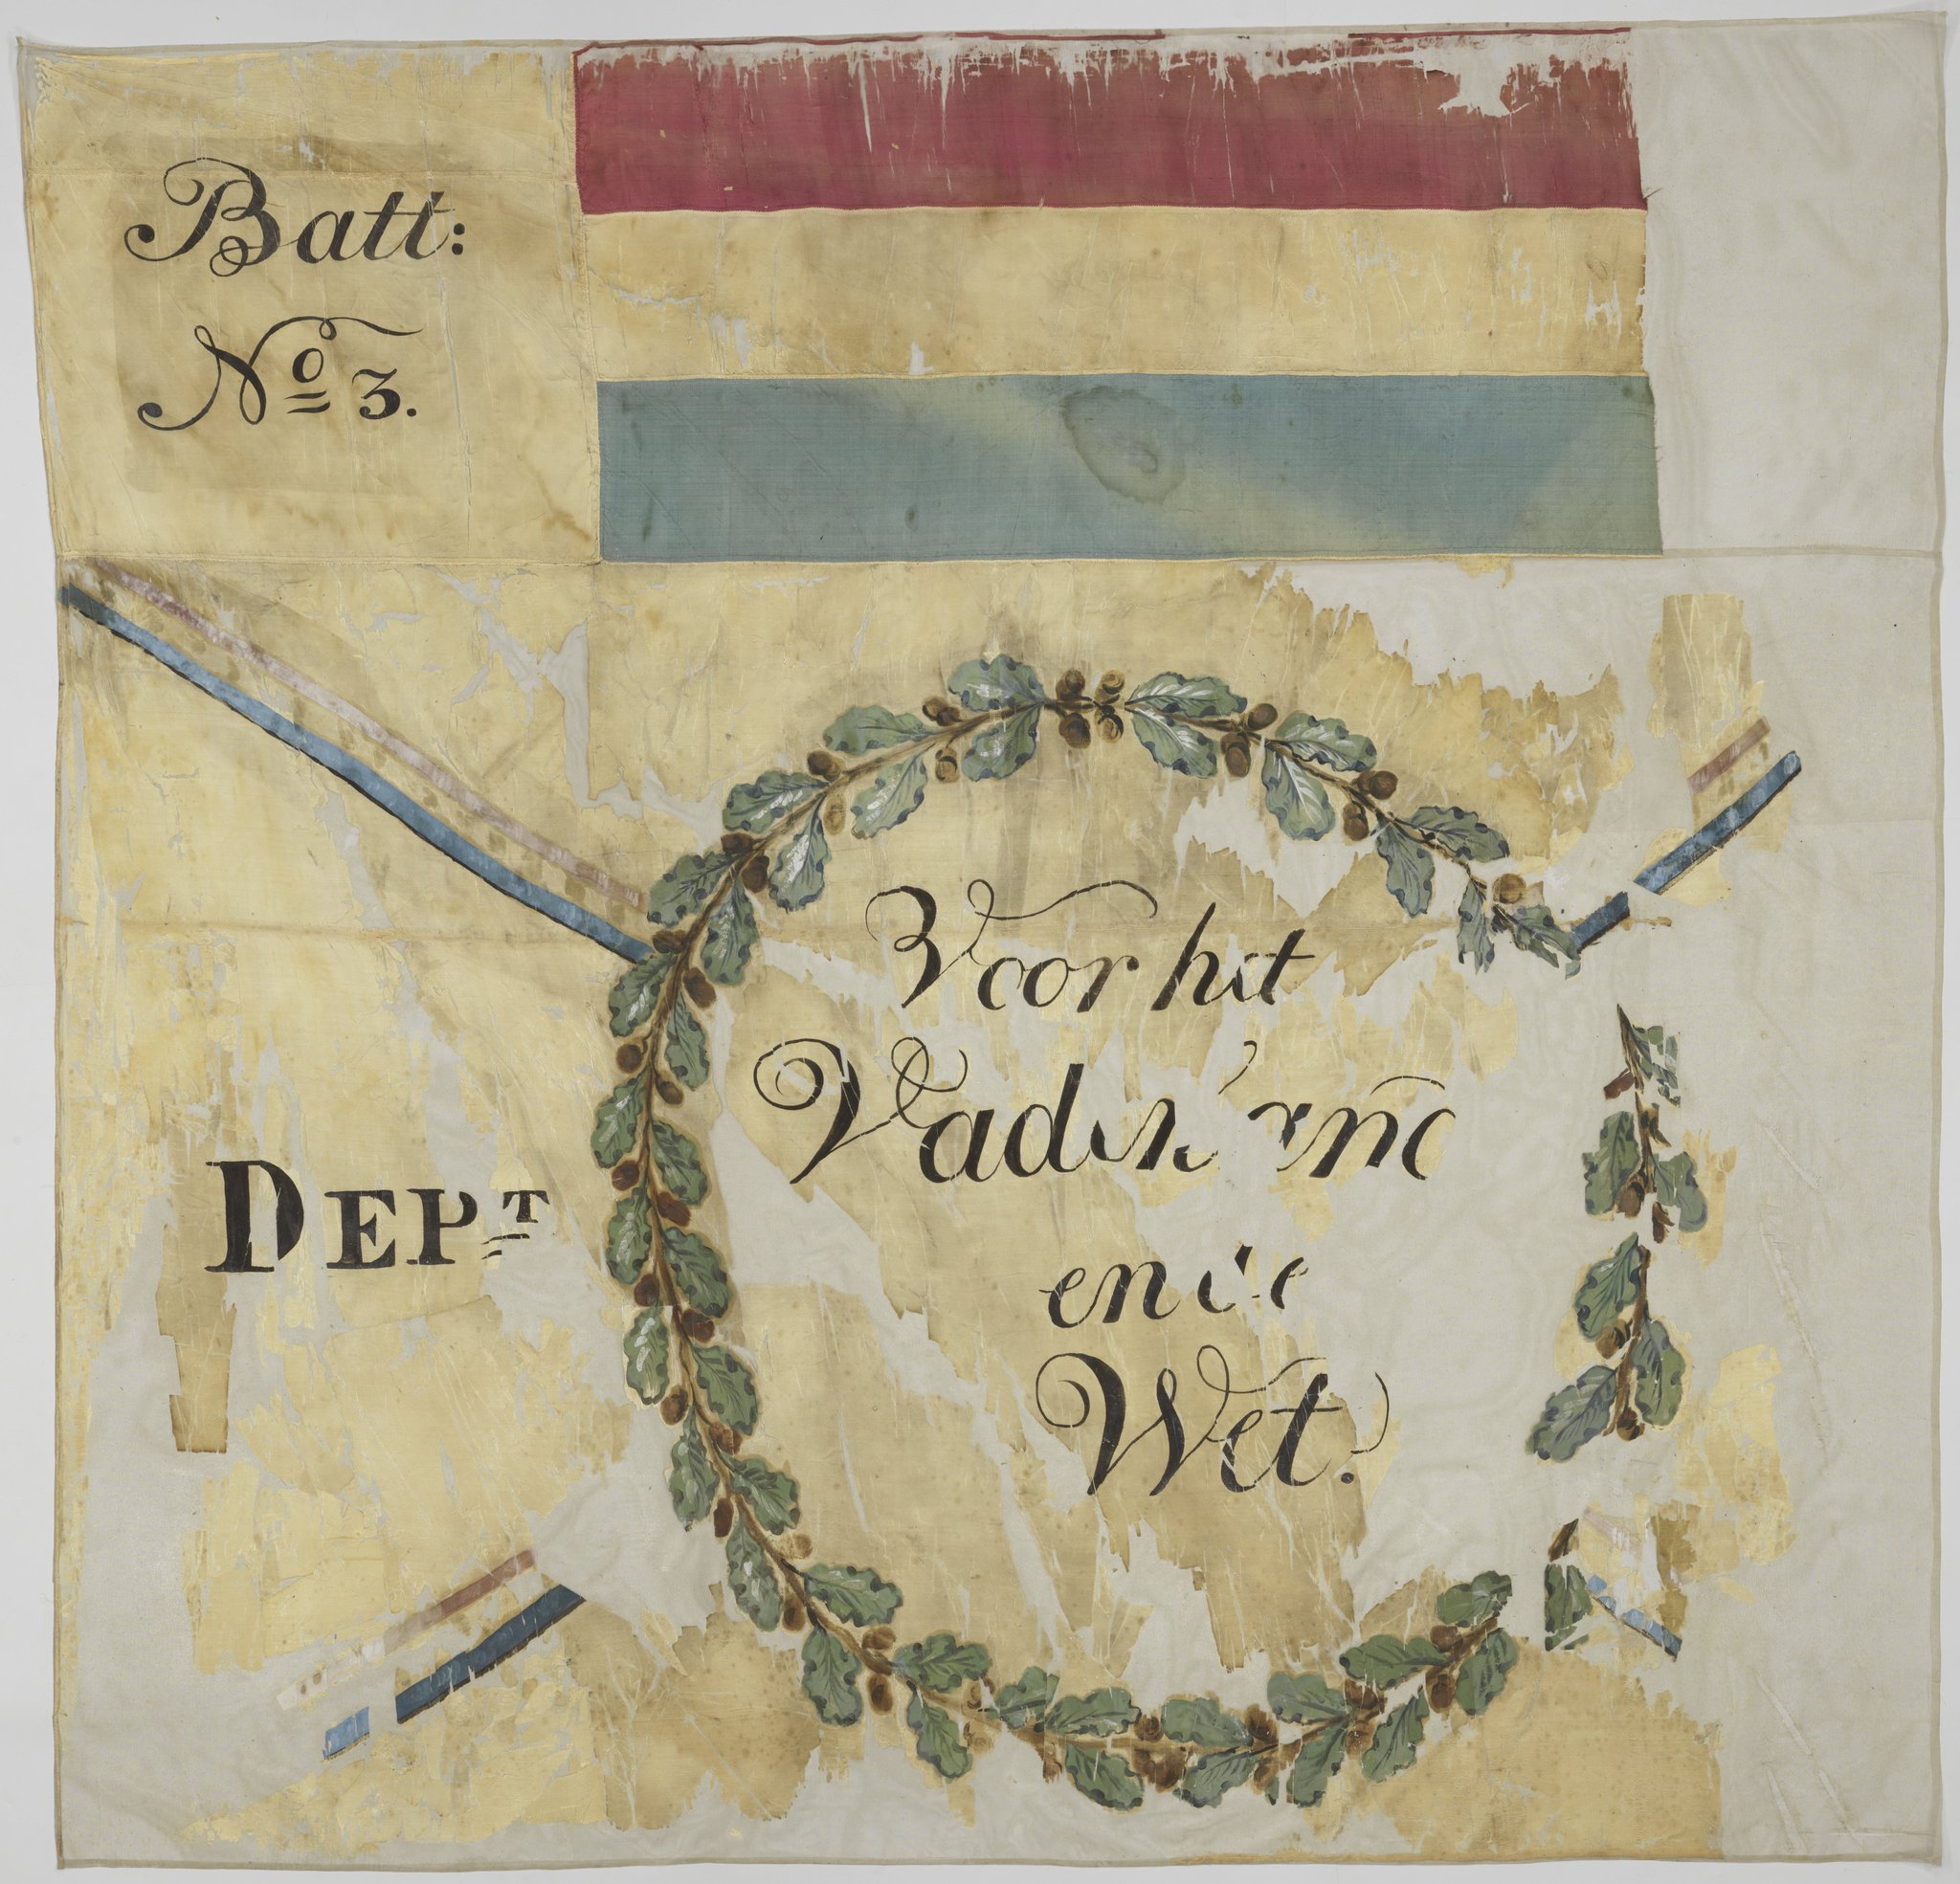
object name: banner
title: Vaandel van het derde bataljon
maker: Anonymous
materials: paint, silk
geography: amsterdam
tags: amsterdam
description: Wit met een krans van eiketakken, waarin met schrijfletters: Voor het Vaderland en de Wet. Diagonaalsgewijs linten rood-wit-blauw achter de krans. Links van de krans:DEPT. Wat rechts heeft gestaan is niet meer aanwezig. Aan de bovenzijde banen rood-wit-blauw. In de bovenhals een rechthoek met in zwarte schrijfletters: Batt:No.3.